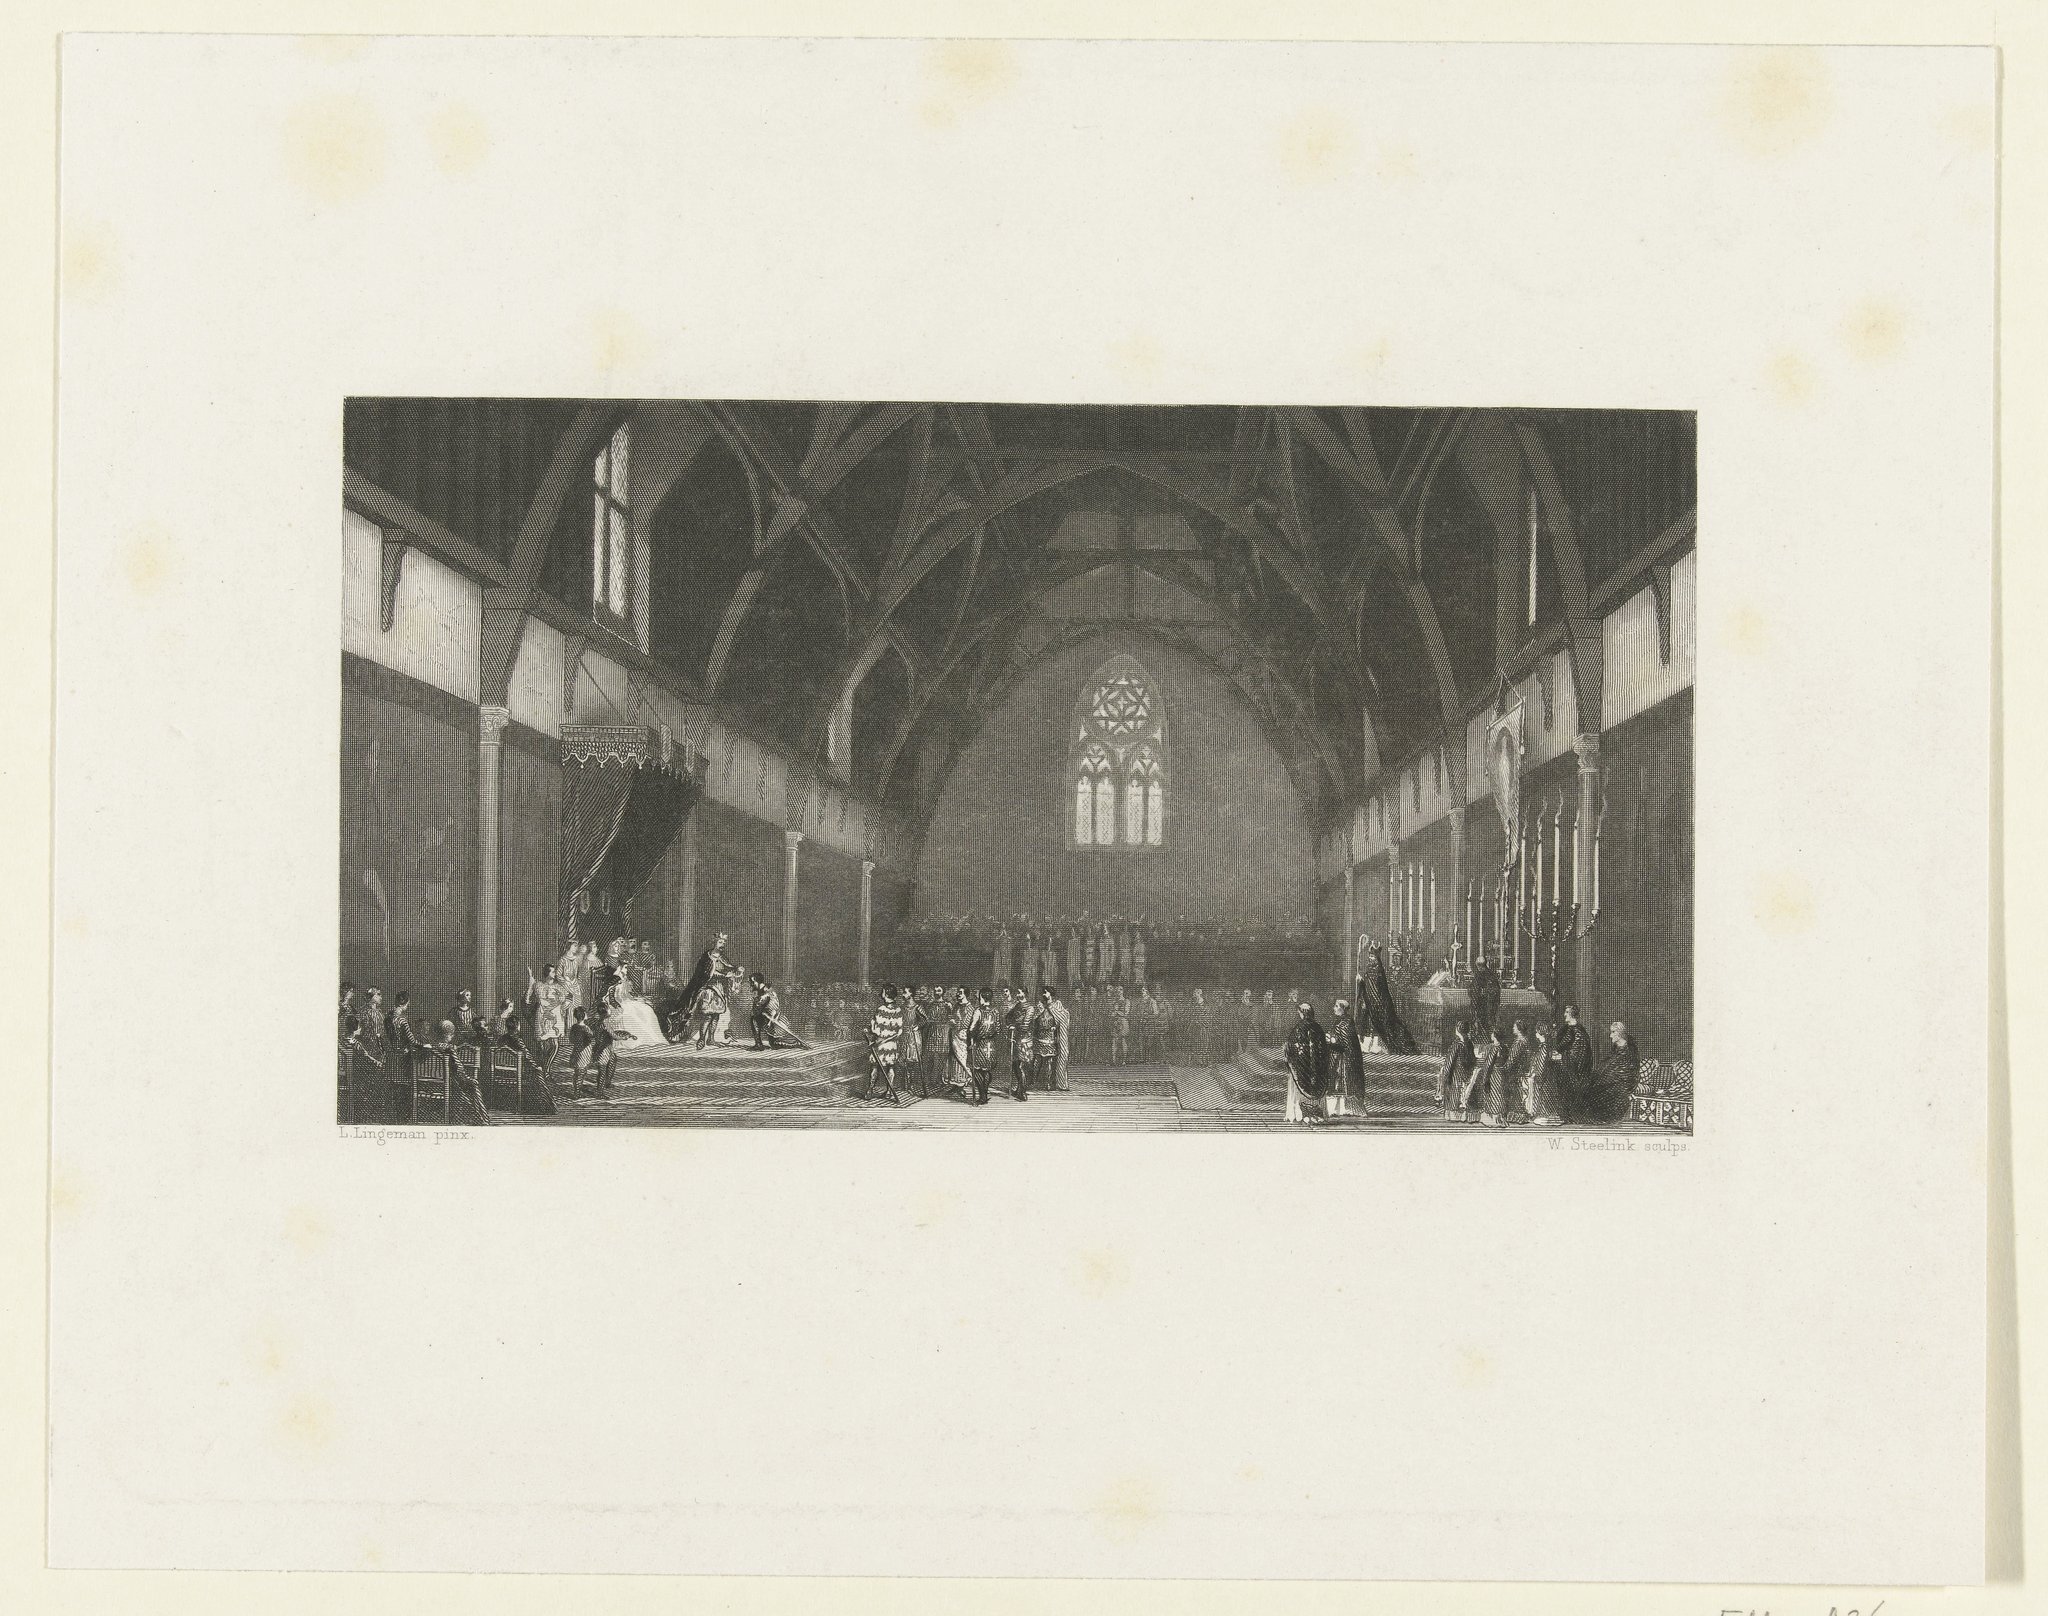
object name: print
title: Graaf Floris V sticht de orde van St. Jacob, 1290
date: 1865-1870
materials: paper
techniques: engraving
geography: netherlands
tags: leiden, floris v (graaf van holland en zeeland), knighthood order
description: Illustratie voor: J. van Lennep en W. Moll en J. ter Gouw, Nederlands geschiedenis en volksleven in schetsen, A.W. Sijthoff, Leiden ca. 1870. Staalgravures naar de schilderijen van de Historische Galerij der Maatschappij Arti en Amicitiae.